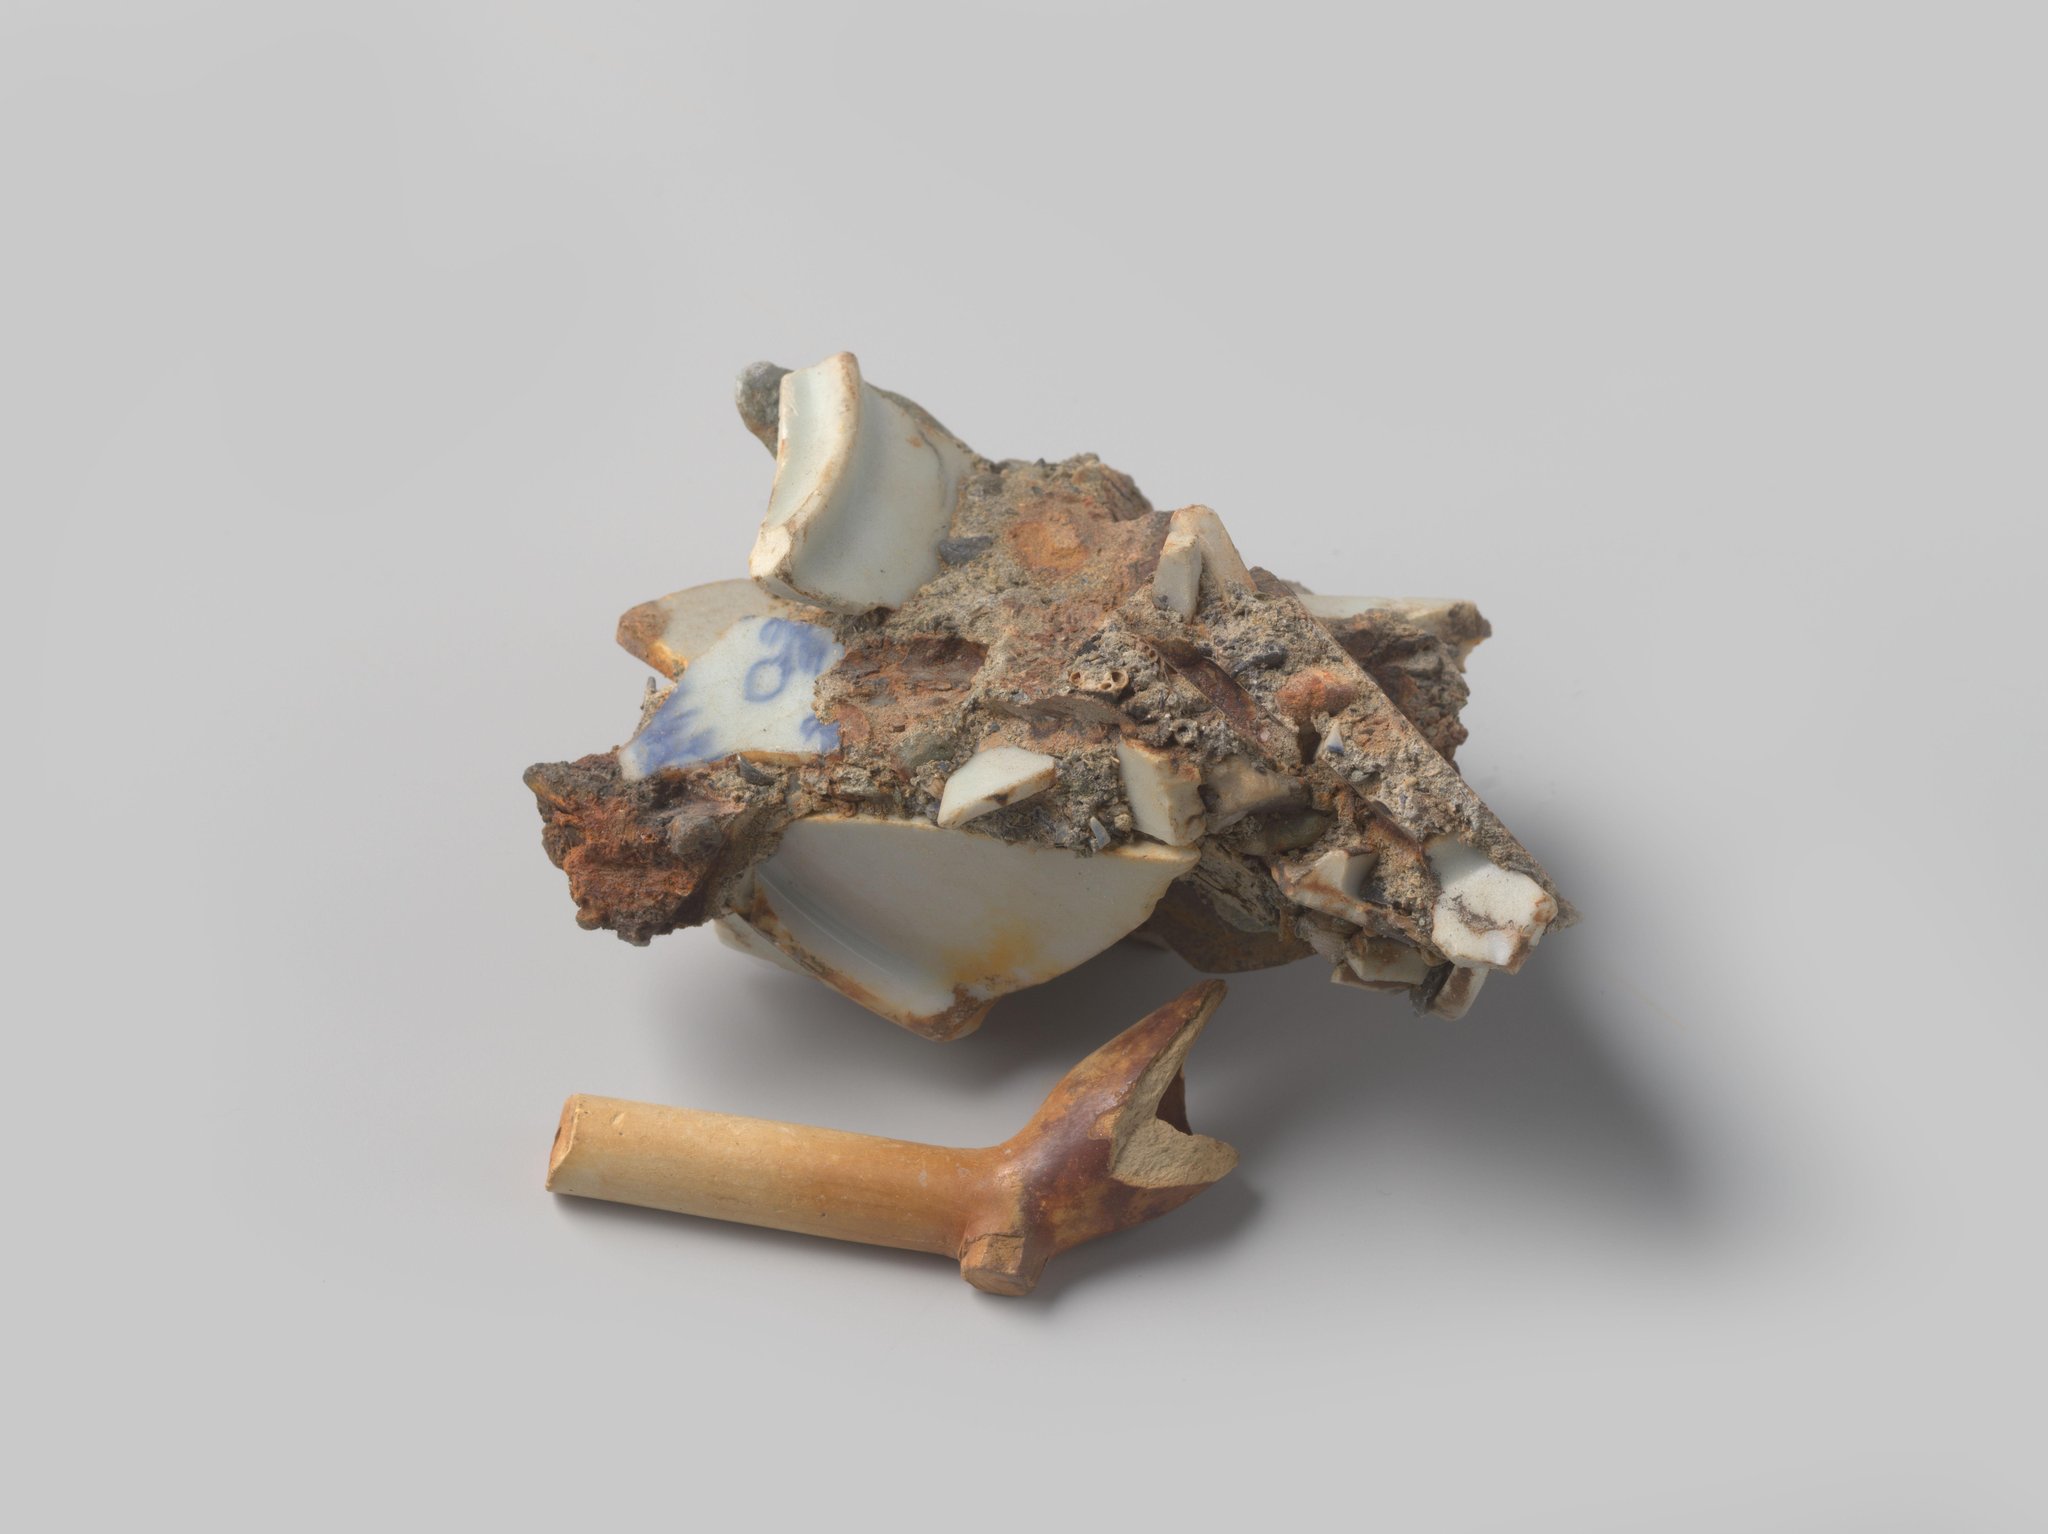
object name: concretionary stone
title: Brok concretie met insluitsels van natuursteen en porselein en een fragment van een pijp uit het wrak van de Oostindiëvaarder Hollandia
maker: Anonymous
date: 1700-1743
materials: stone, clay, porcelain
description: Brok concretie met insluitsels van natuursteen en porselein en een fragment van een pijp.